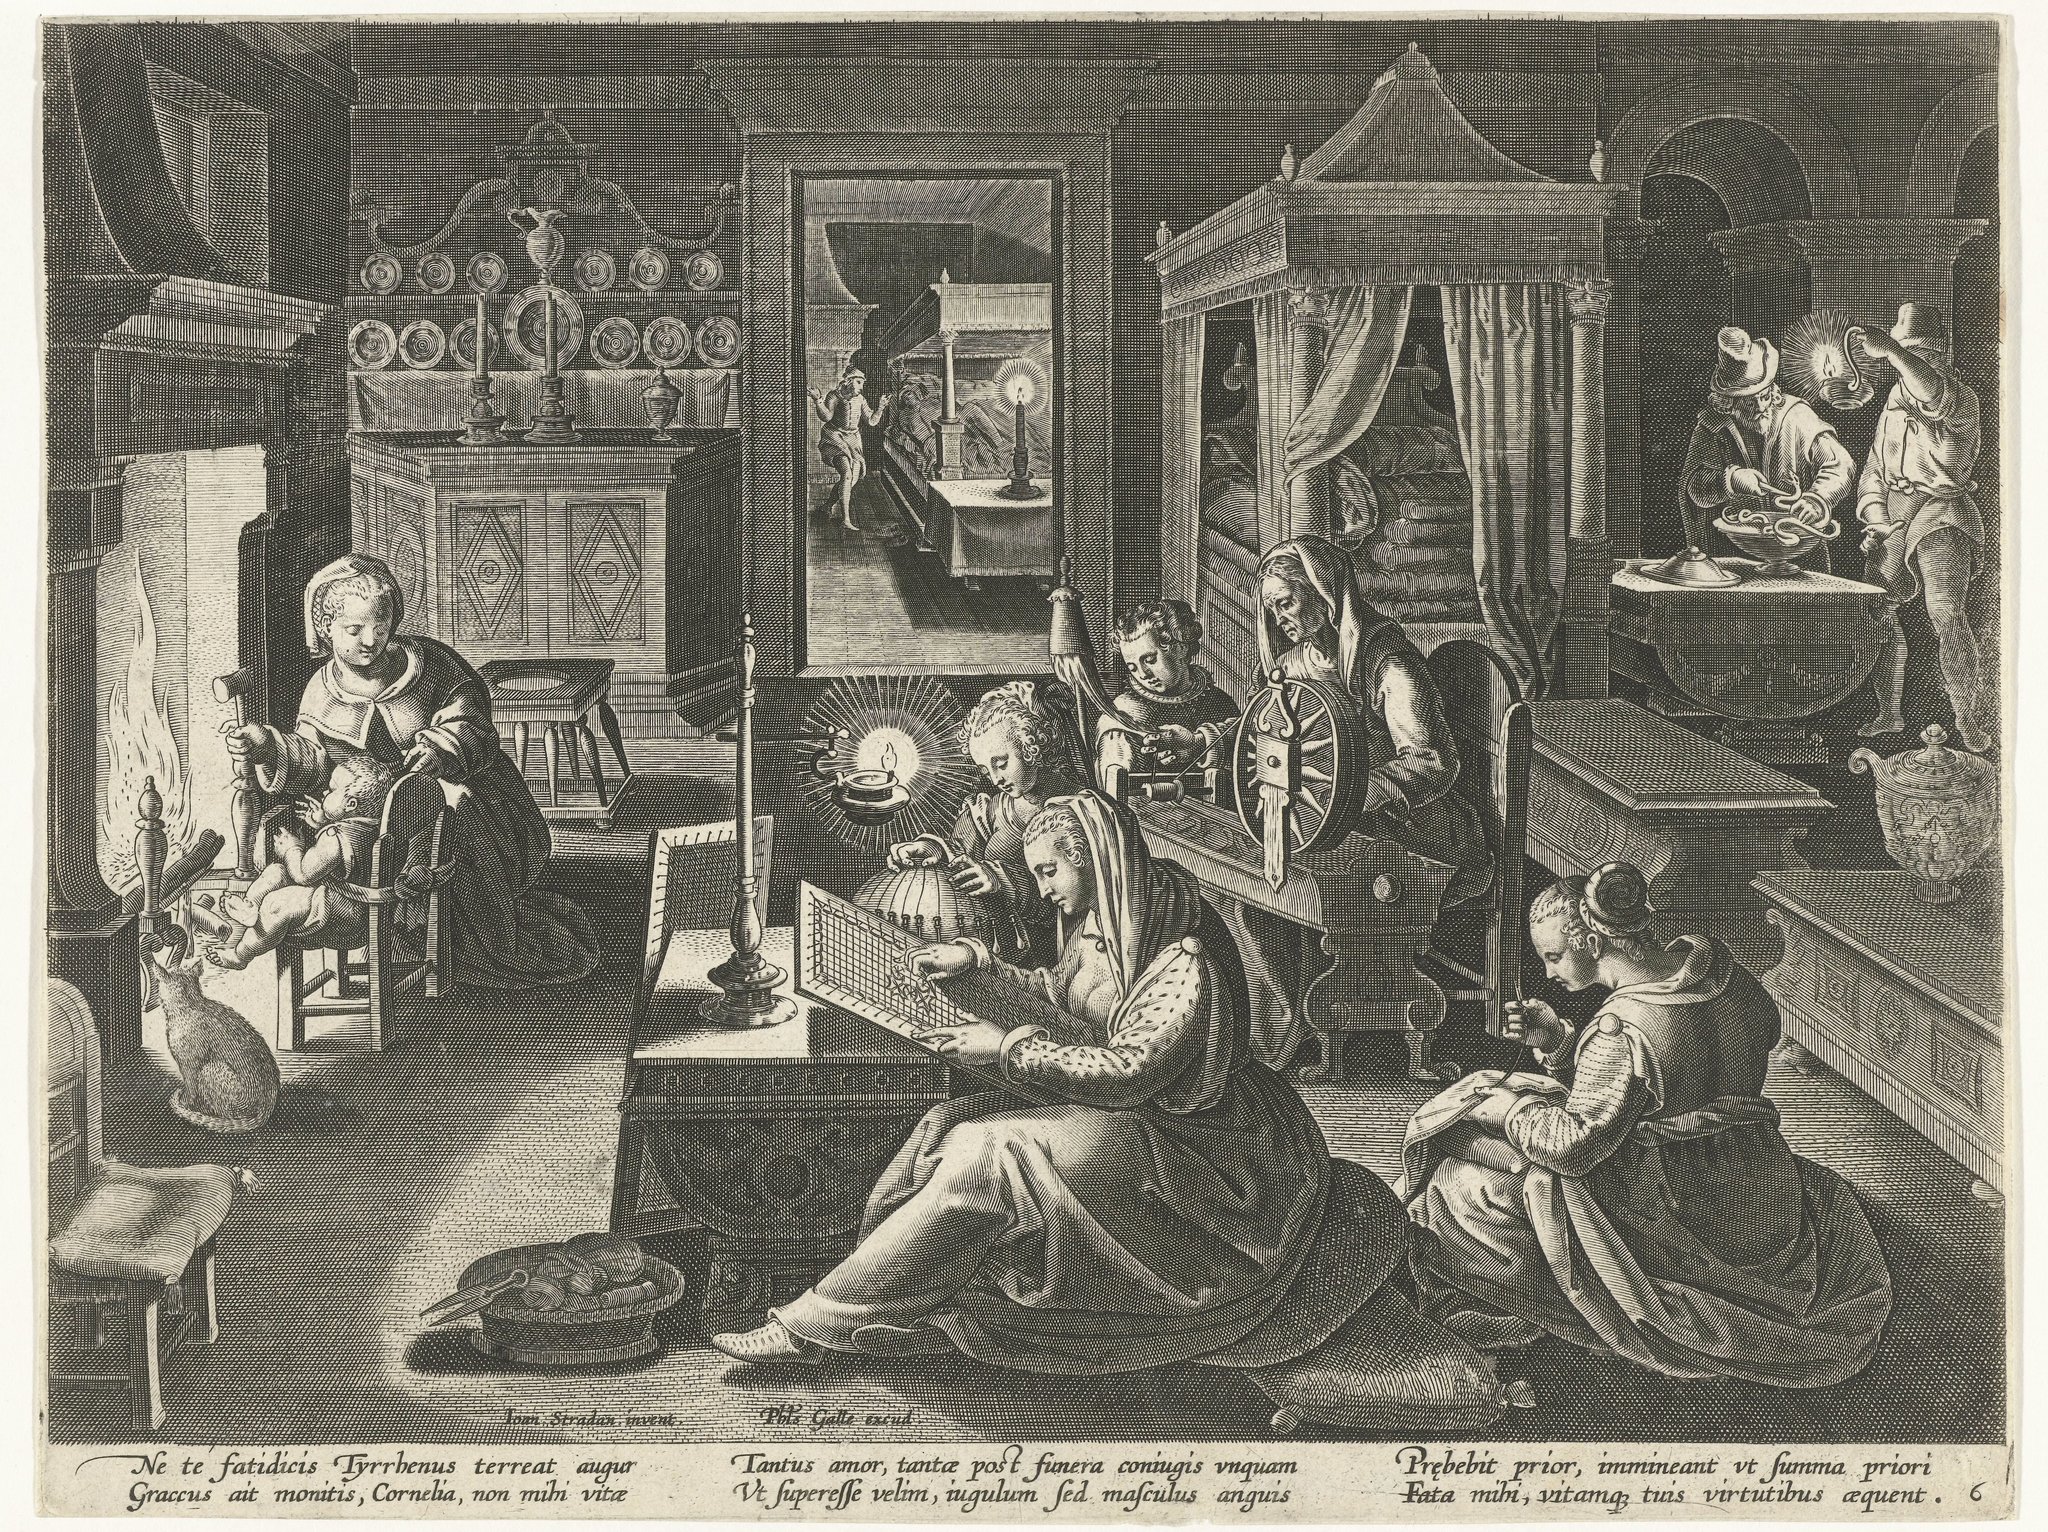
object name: print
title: Beroemde Romeinse vrouwen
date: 1593-1597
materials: paper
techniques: engraving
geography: antwerp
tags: (story of) cornelia, mother of the gracchi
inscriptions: collector's mark: Lugt 2760, collector's mark: Lugt 2228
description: Cornelia, vrouw van Tiberius Gracchus en moeder van de gebroeders Gracchi als deugdzame huisvrouw. Zij wordt voorgesteld als een goede moeder die met haar kind speelt en als een vlijtige huisvrouw die zich bezighoudt met naai- en haakwerk. Op de achtergrond rechts doodt haar man Tiberius een slang. De prent heeft een Latijns onderschrift en maakt deel uit van een zesdelige serie over beroemde Romeinse vrouwen.